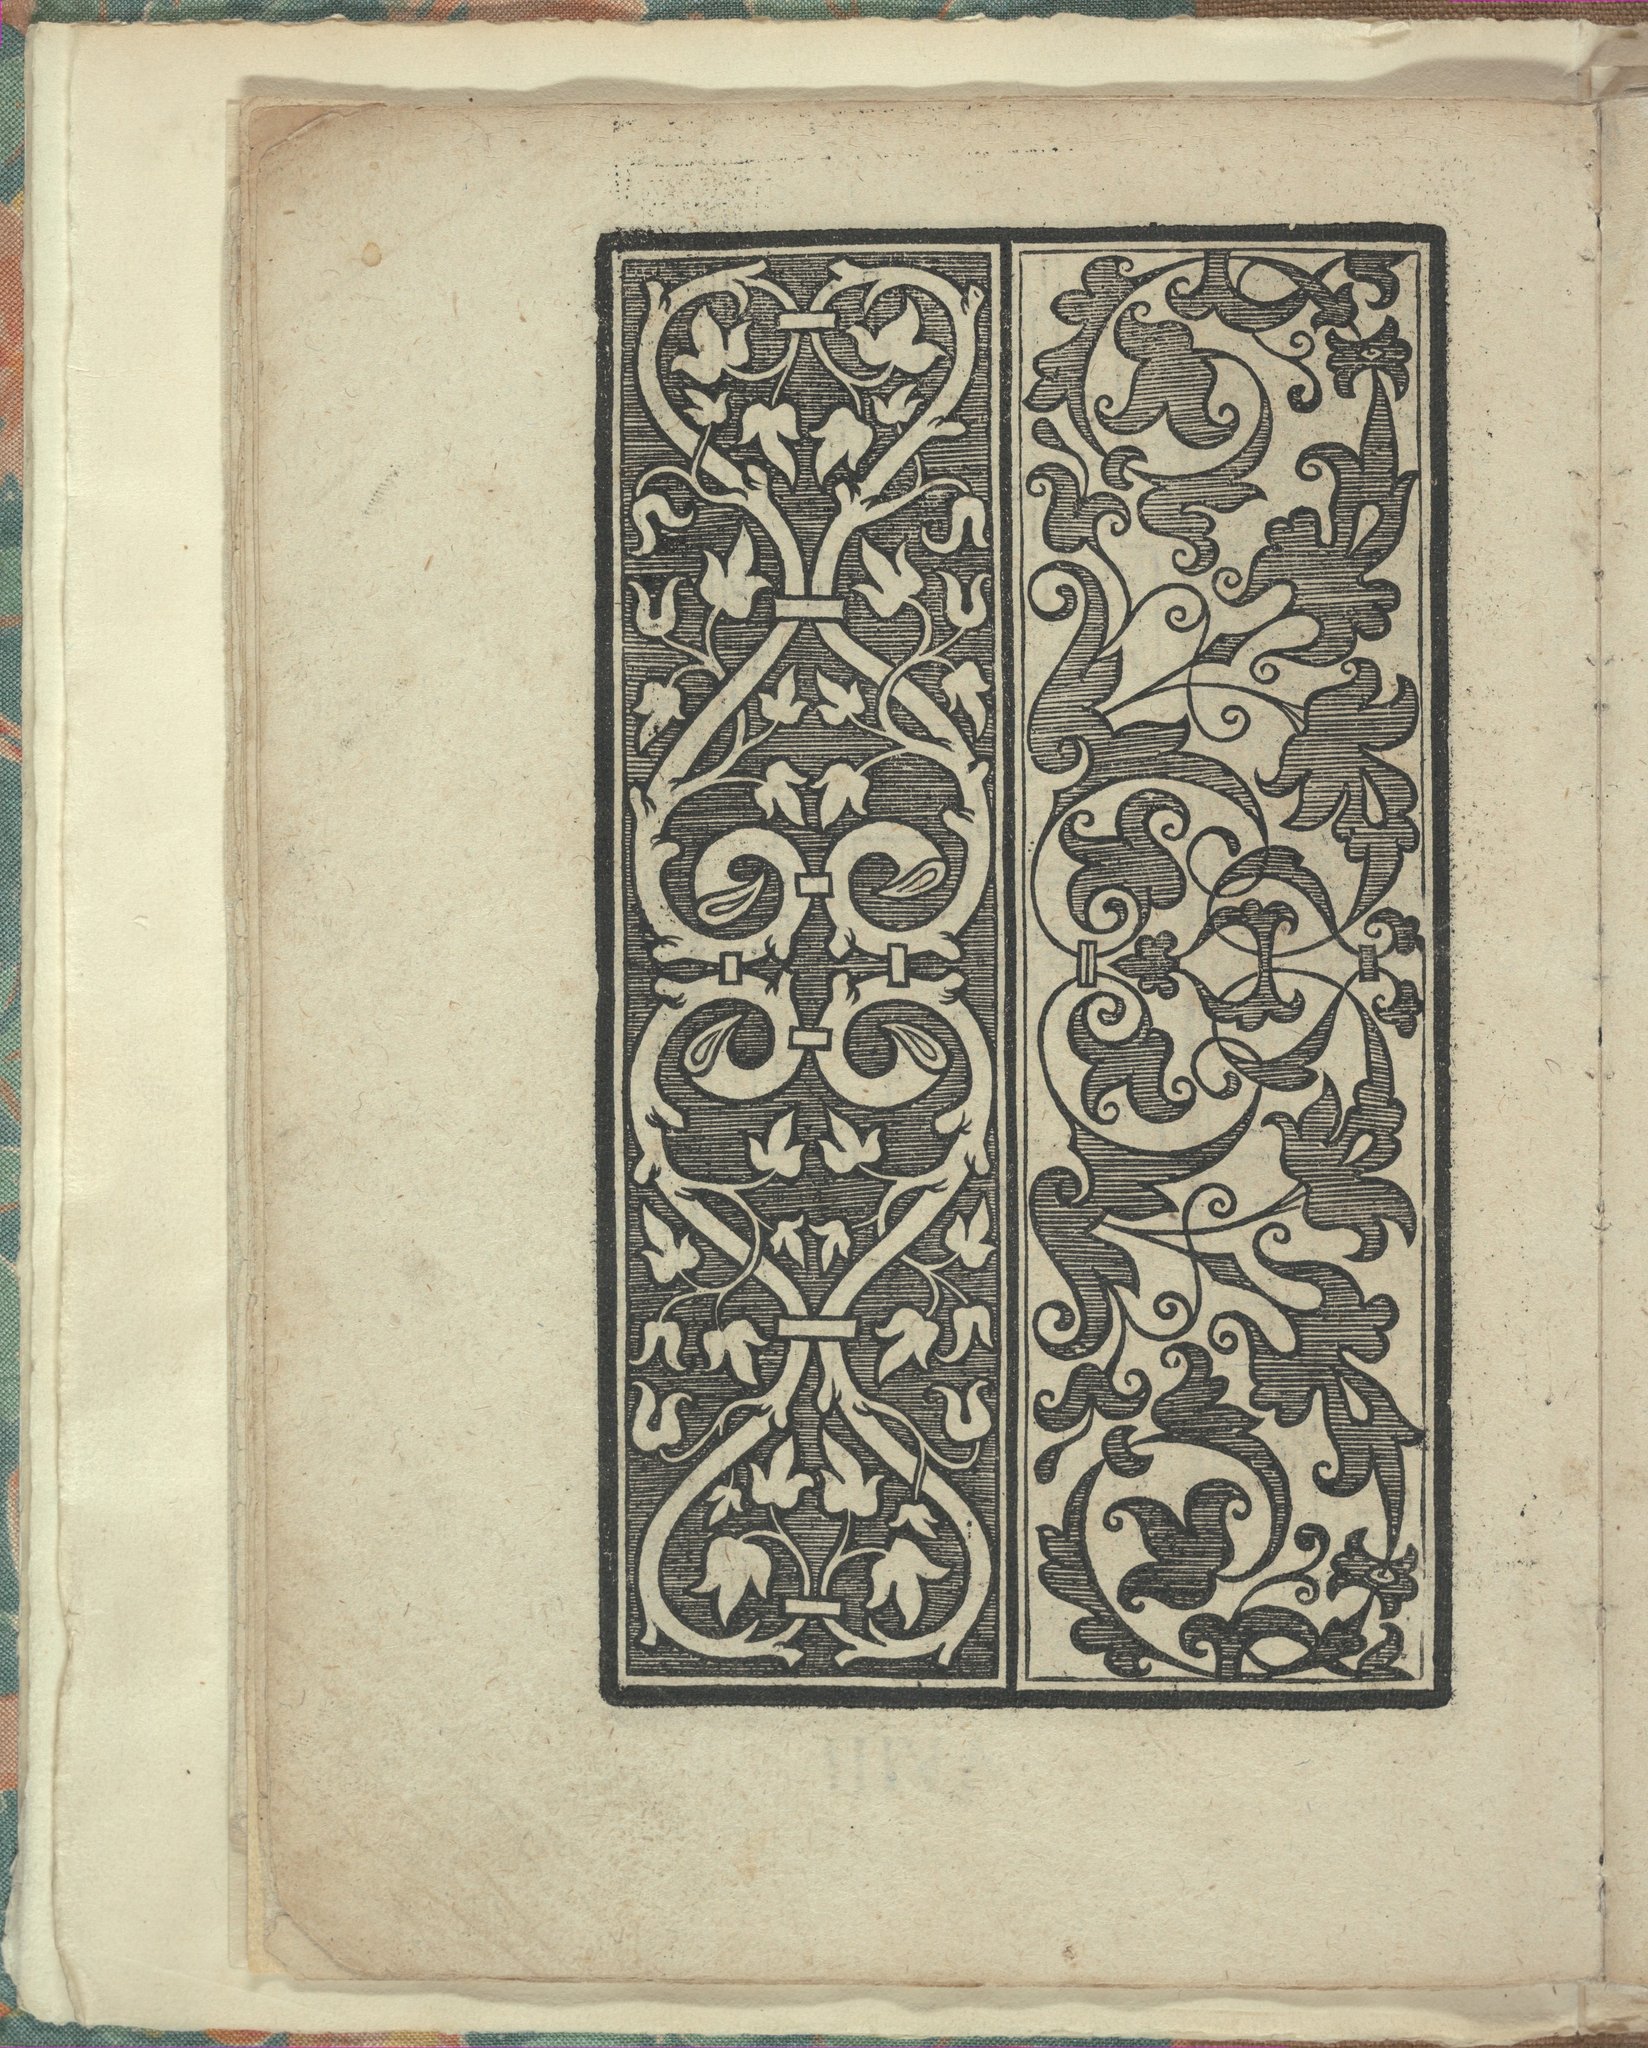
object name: book print ornament architecture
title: Opera Nova Universali intitulata Corona di racammi, page 8 (verso)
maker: giovanni andrea vavassore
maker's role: publisher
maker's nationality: italian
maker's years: 1530-1573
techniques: woodcut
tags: flowers,leaves